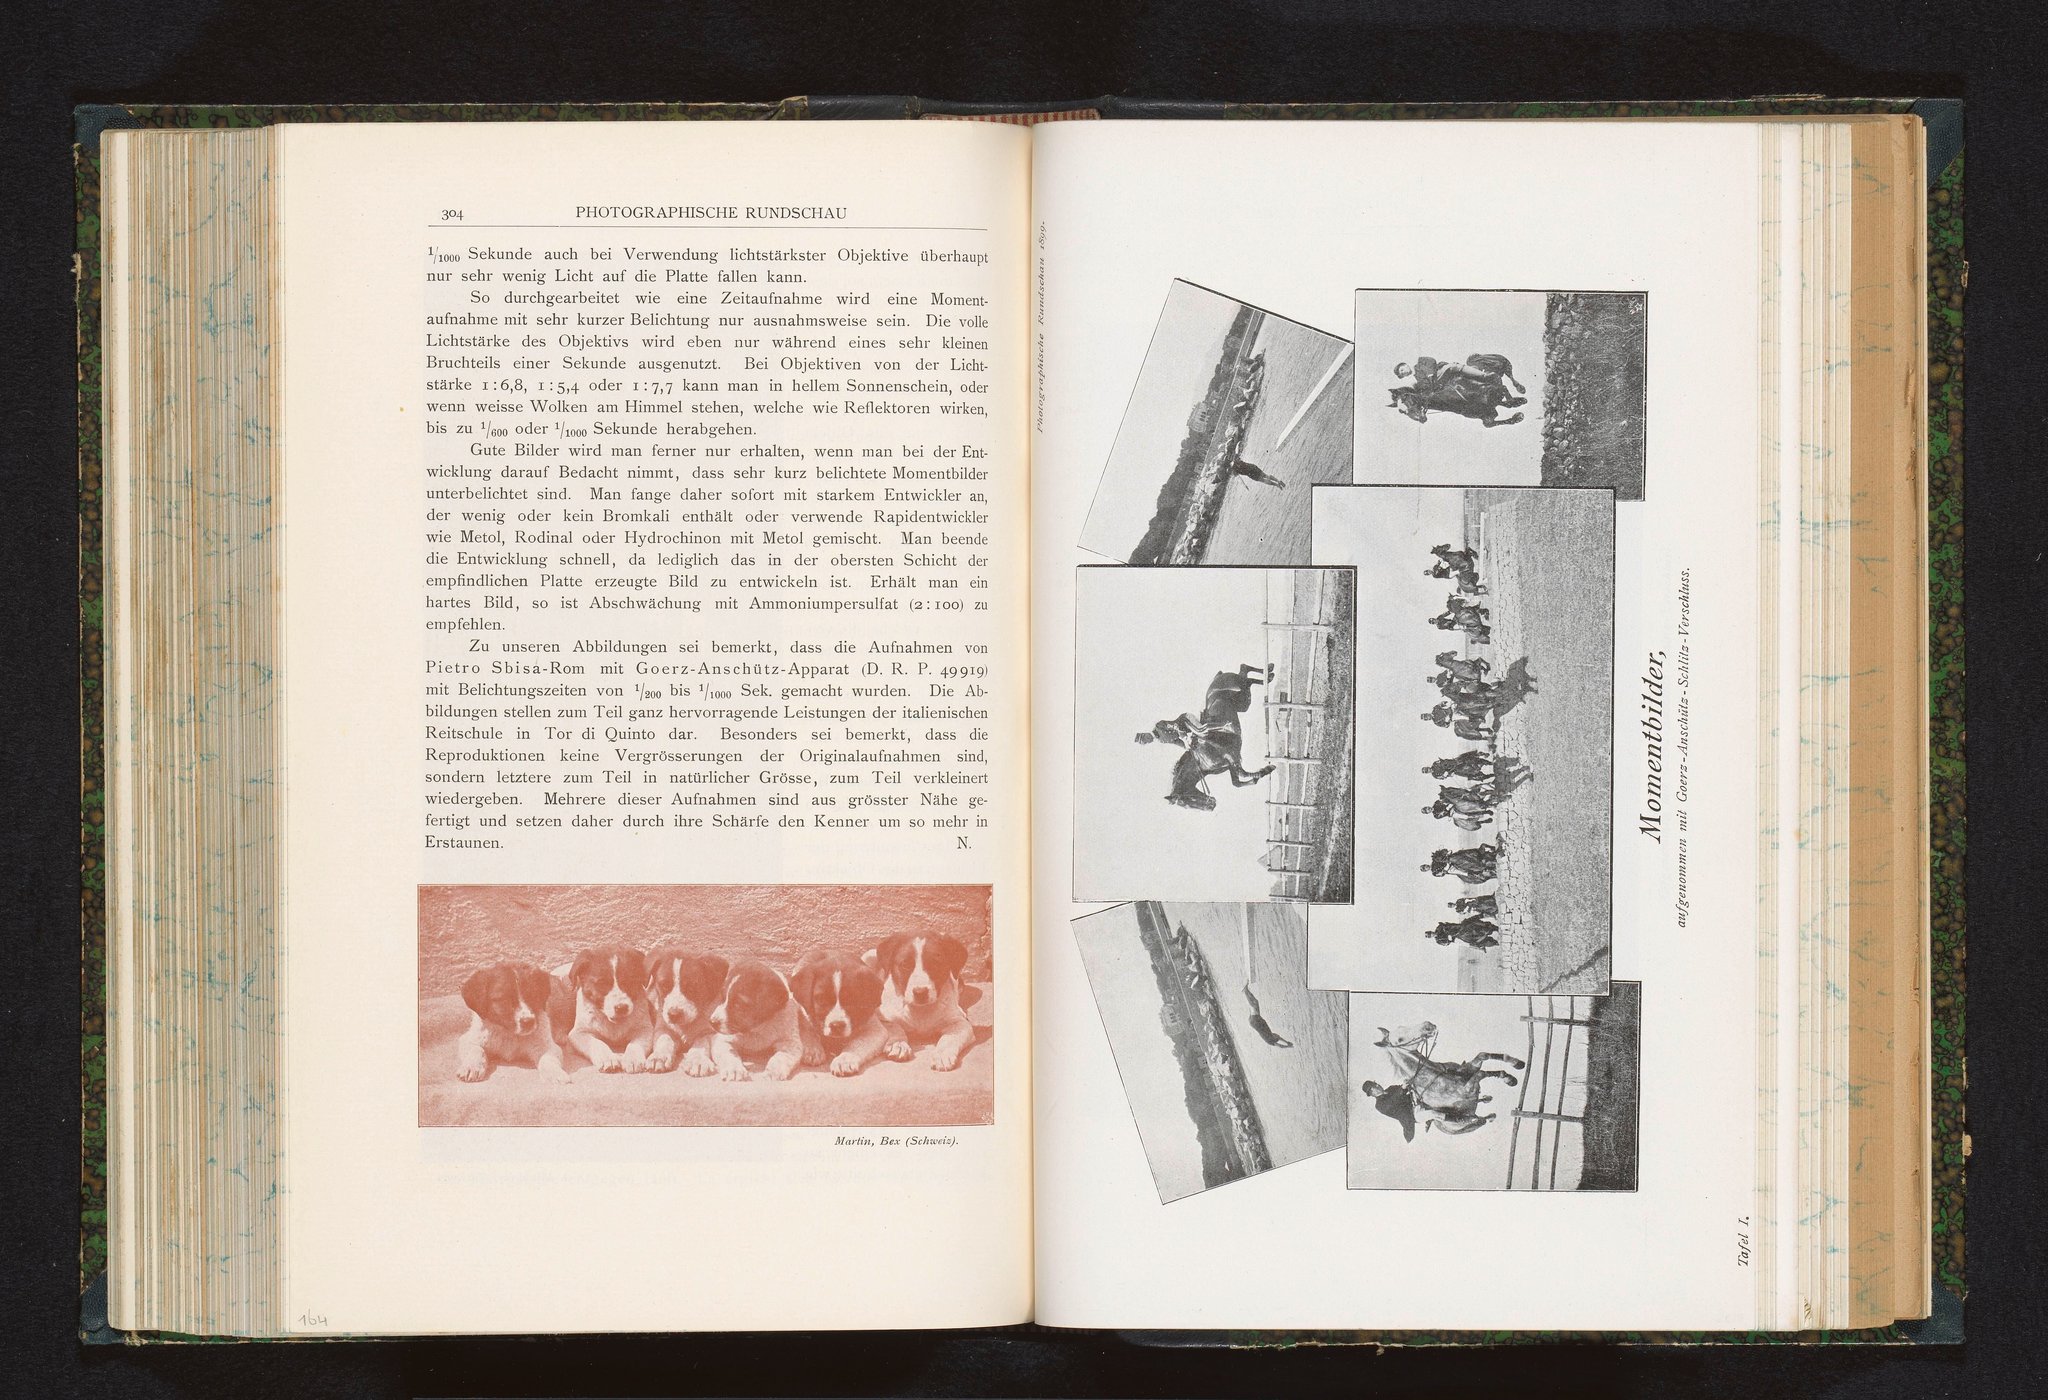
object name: photomechanical print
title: Collage van foto's van paardensport en zwemmen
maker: Anonymous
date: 1894-1899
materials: paper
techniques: autotype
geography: berlin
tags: swimming (sport), jumping (horse in motion)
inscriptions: inscription: ‘Tafel I.’, inscription: ‘augenommen mit Goerz-Anschütz-Schlitz-Verschluss.’